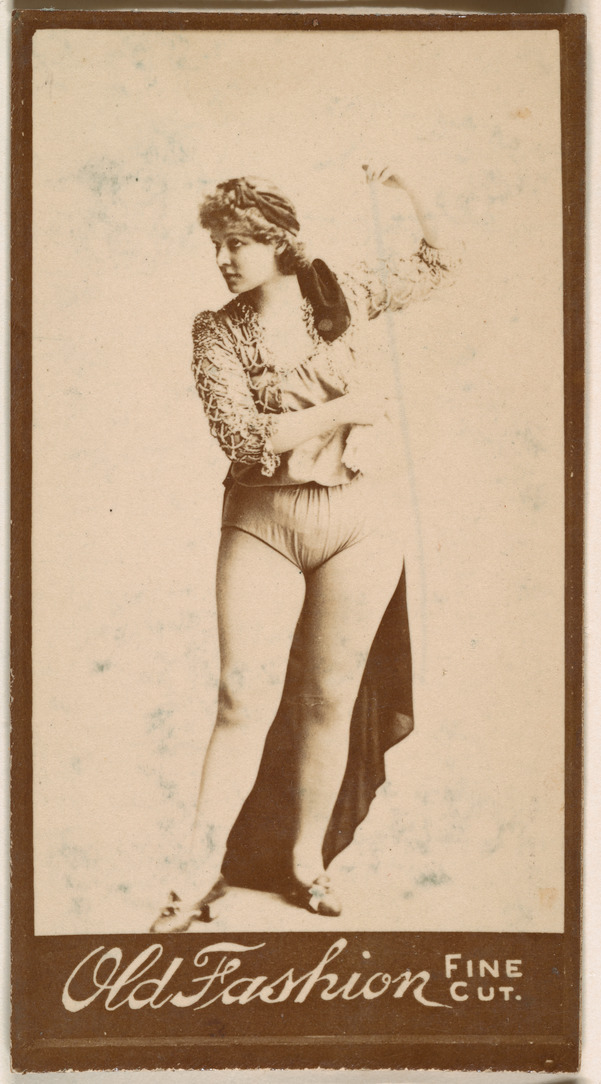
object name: photograph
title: Actress standing with arm aloft, from the Actresses series (N664) promoting Old Fashion Fine Cut Tobacco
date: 1888-1890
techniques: albumen silver print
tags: portraits,women,actresses